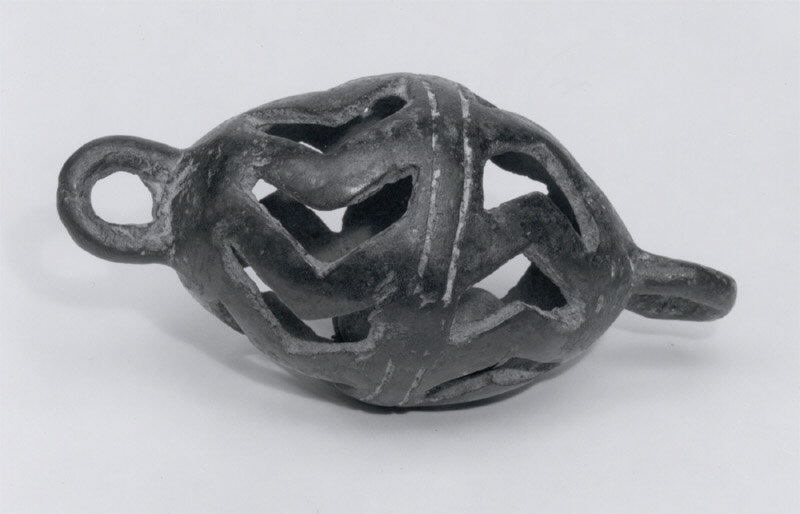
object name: rattle bell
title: Openwork rattle bell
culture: iranian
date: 900-701 BCE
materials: bronze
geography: iran